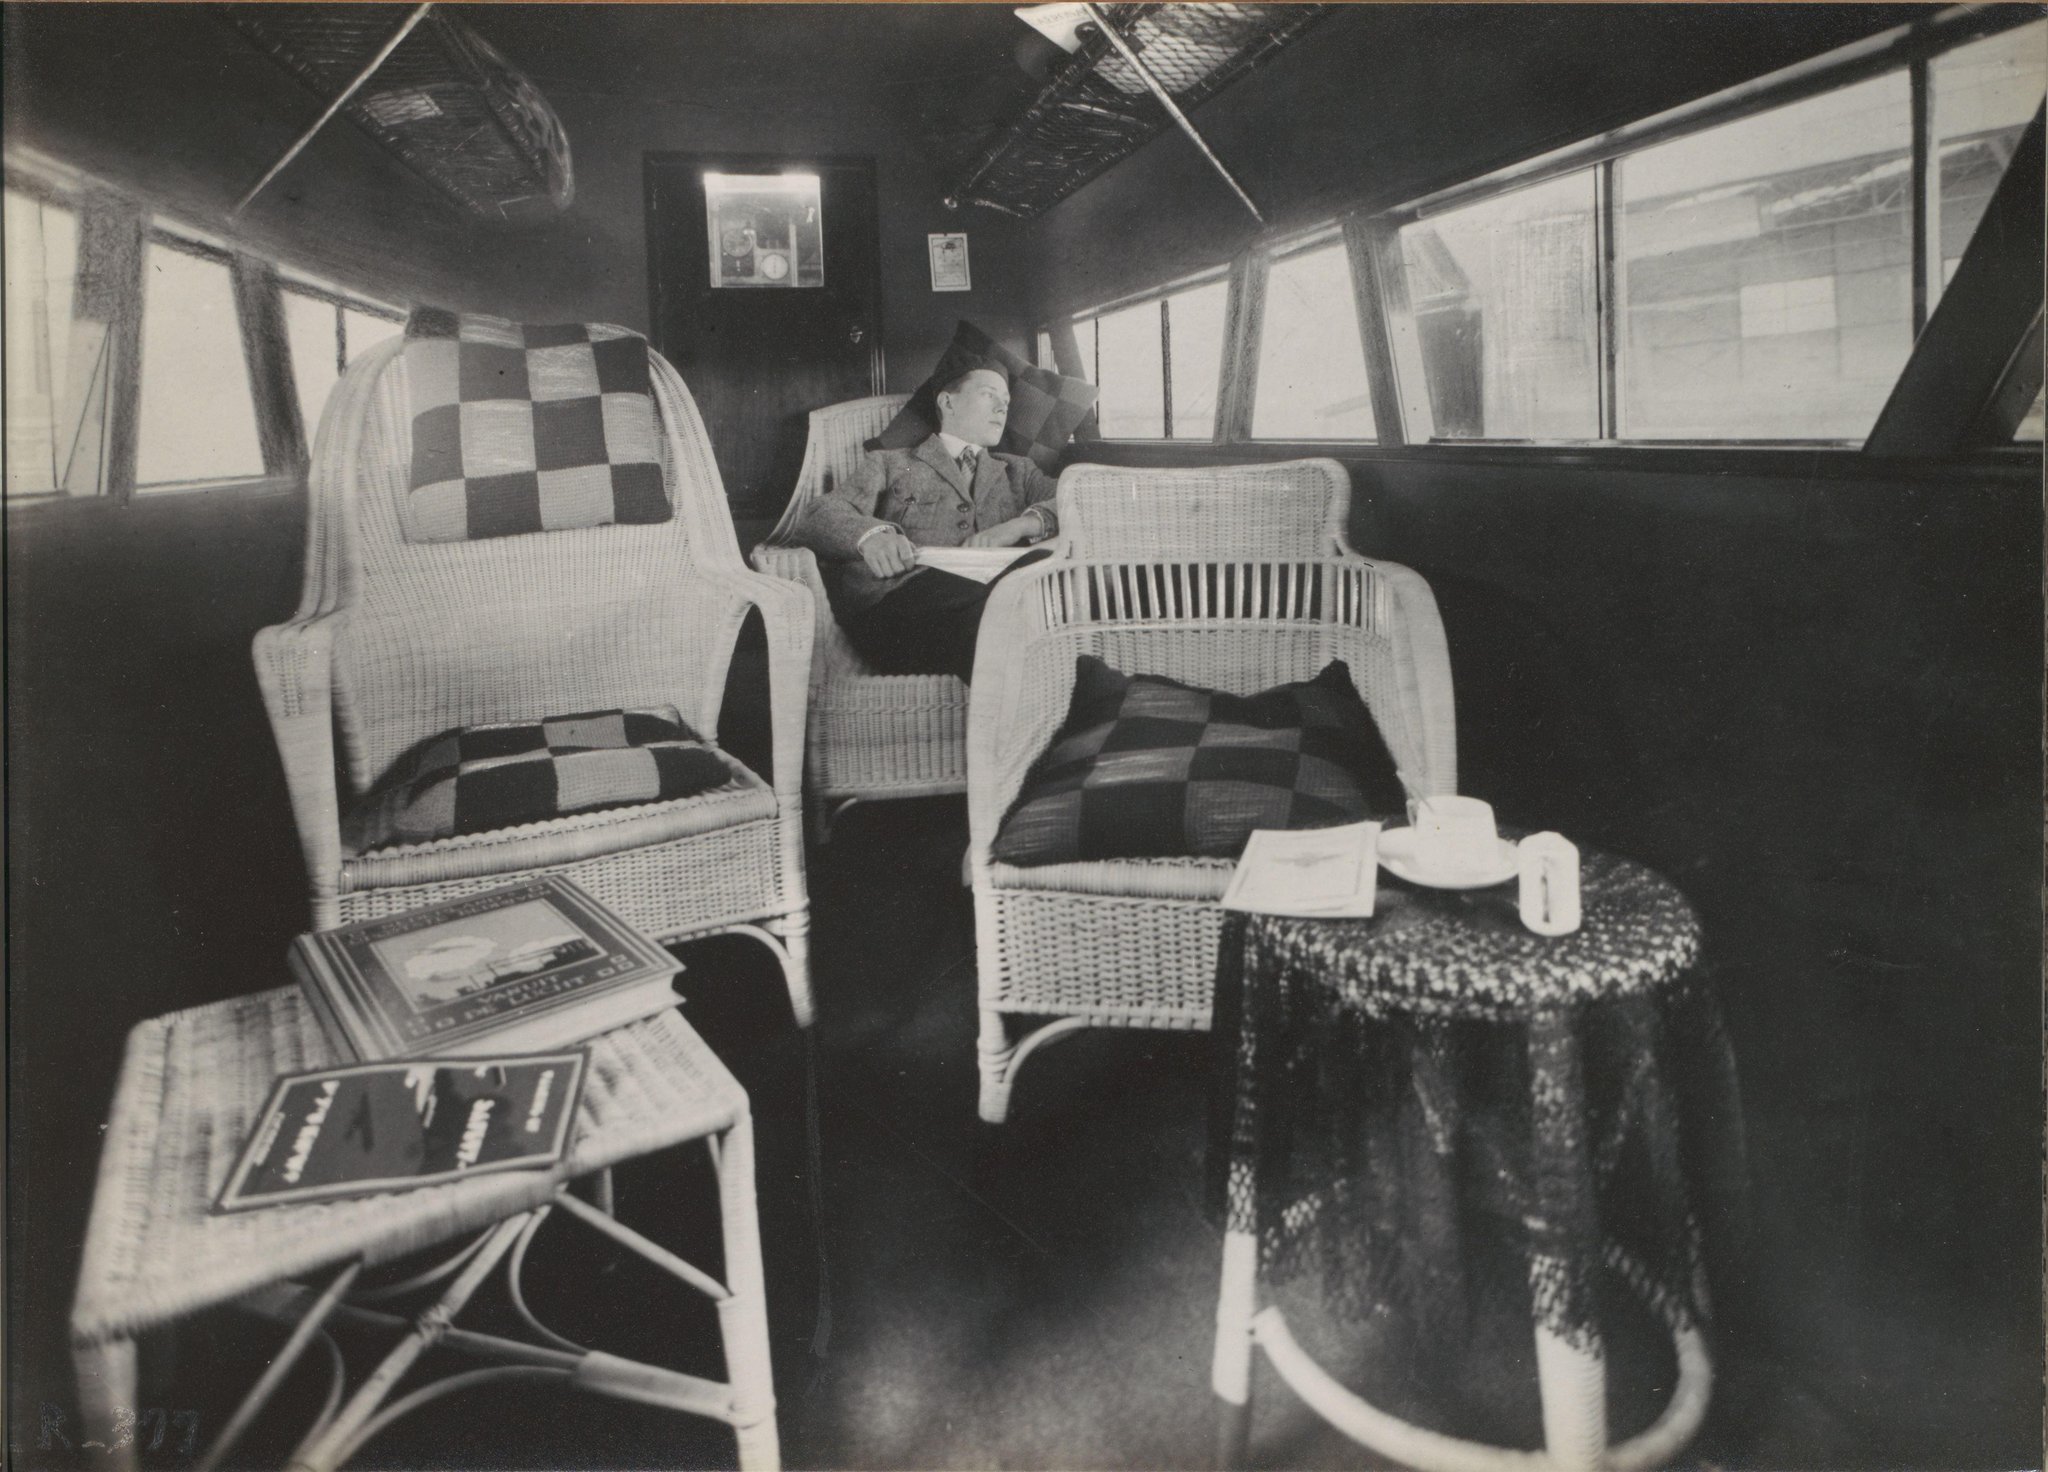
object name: photograph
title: Man in een vliegtuigcabine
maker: Anonymous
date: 1929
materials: cardboard, paper, photographic support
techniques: gelatin silver print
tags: aircraft, aeroplane, airborne traffic, aviation, travelling; tourism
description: Albumblad met een foto van een man zittend in een met rotanstoelen gemeubileerde vliegtuigcabine. Onderdeel van Herdenkingsalbum van de Indië-lijn van de KLM, deel I.